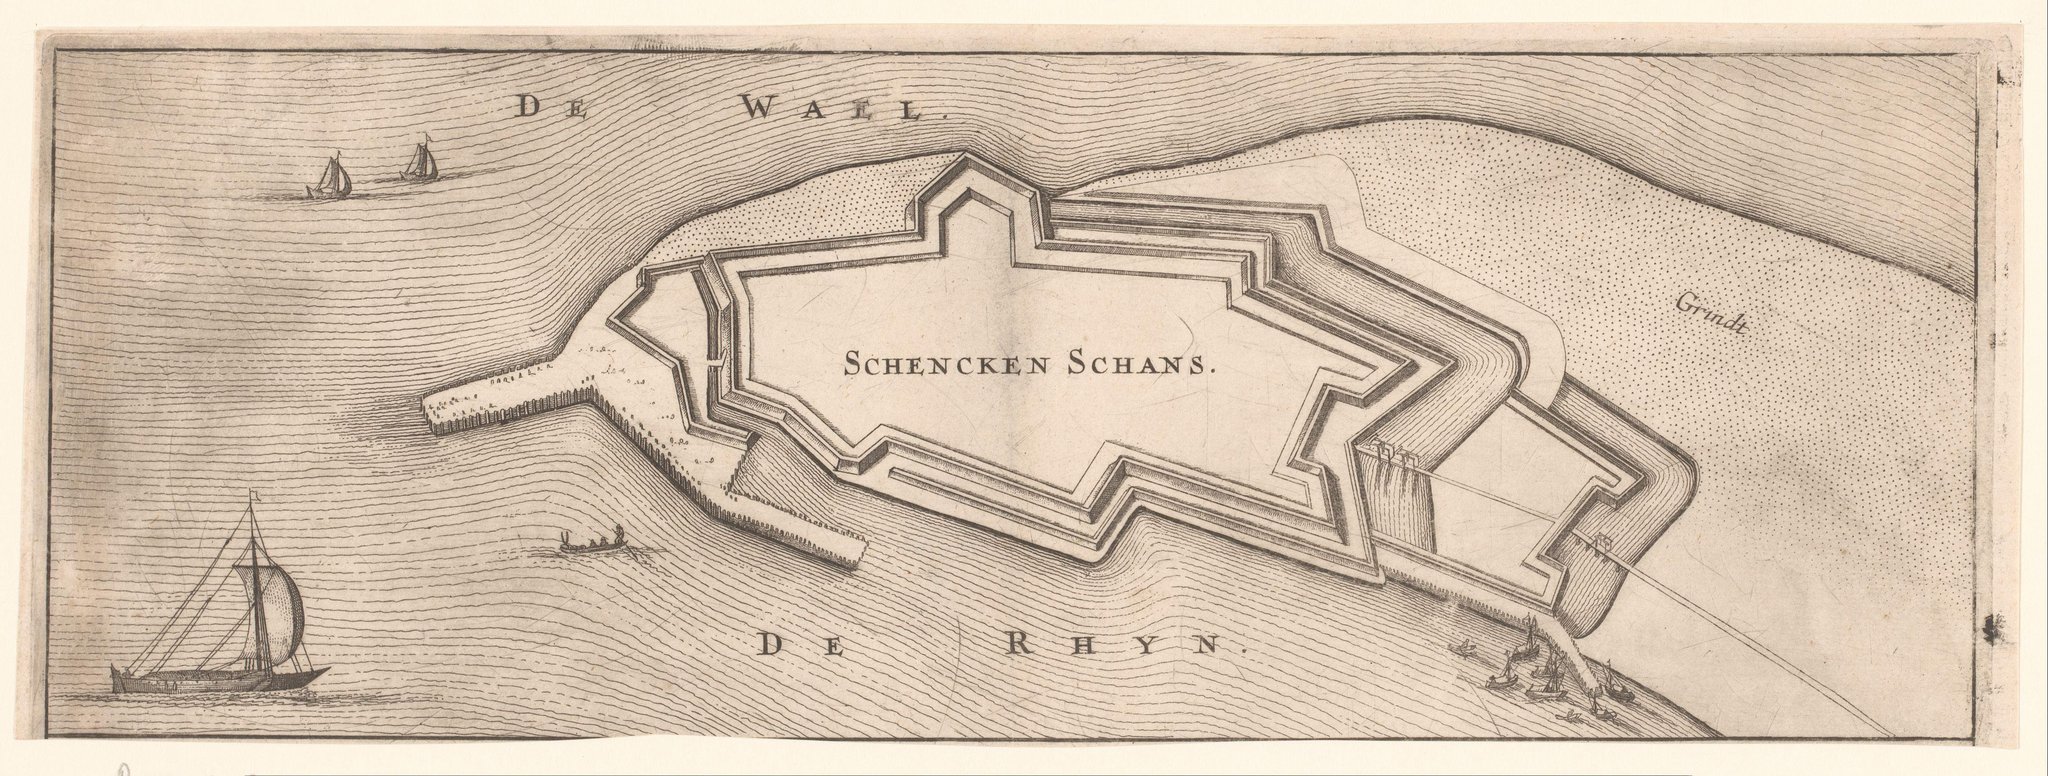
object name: print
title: Plattegrond van Schenkenschanz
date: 1672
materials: paper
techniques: engraving, etching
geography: arnhem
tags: fortress, maps of cities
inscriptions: collector's mark: Lugt 2228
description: Prenten ook gebruikt in: Cartes géographiques du Duché de Gueldre et Comté de Zutphen. Arnhem: Jacob van Biesen, 1672.